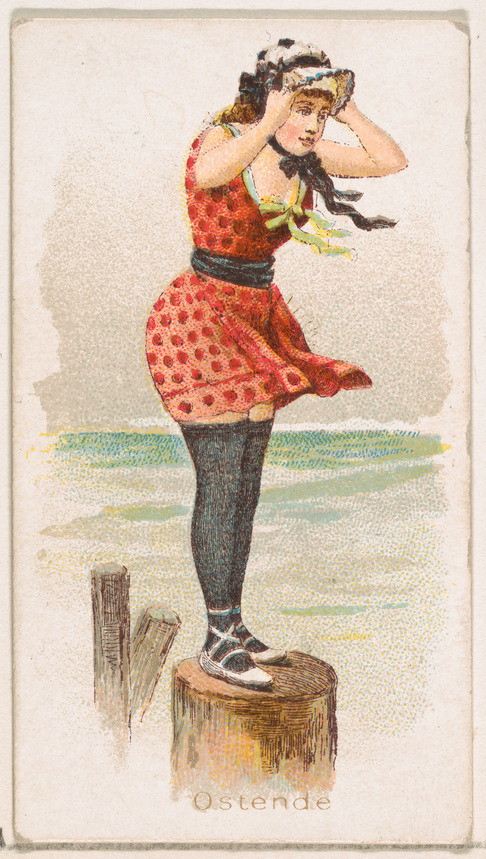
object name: print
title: Ostende, from the Fancy Bathers series (N187) issued by Wm. S. Kimball & Co.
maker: william s. kimball & company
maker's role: publisher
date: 1889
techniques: color lithograph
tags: women